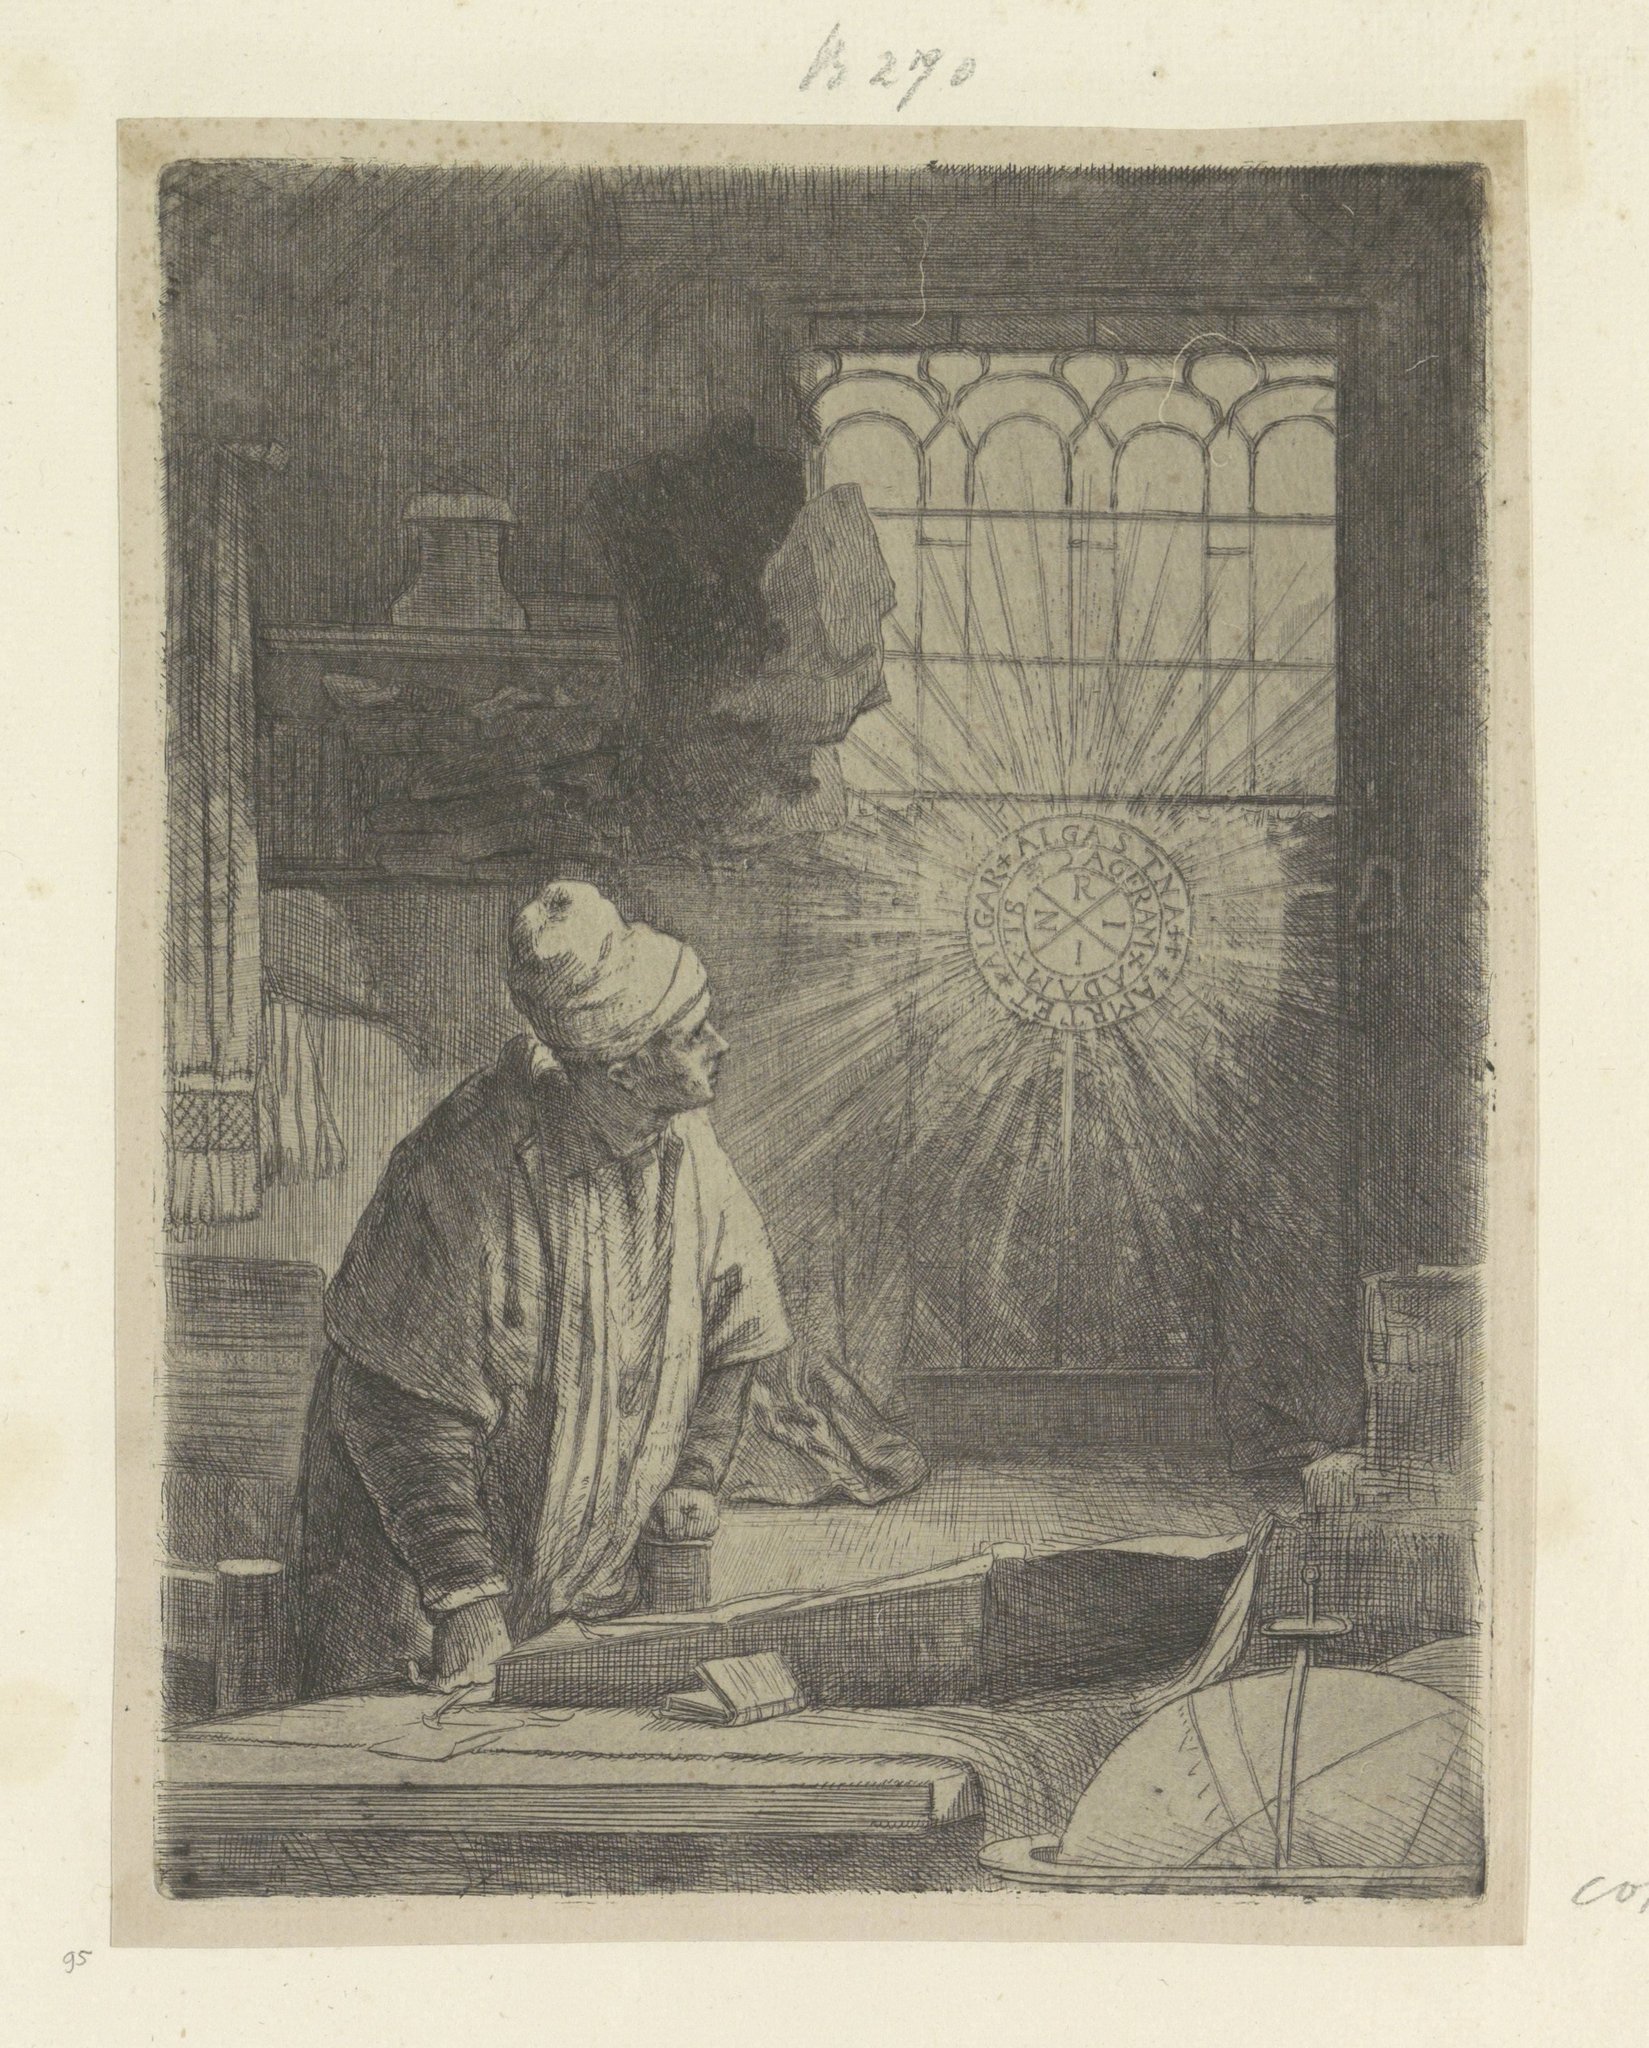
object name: album leaf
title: Recueil de quatre-vingt-cinq estampes originales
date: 1650-1807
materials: paper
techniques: drypoint, engraving, etching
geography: paris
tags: faust